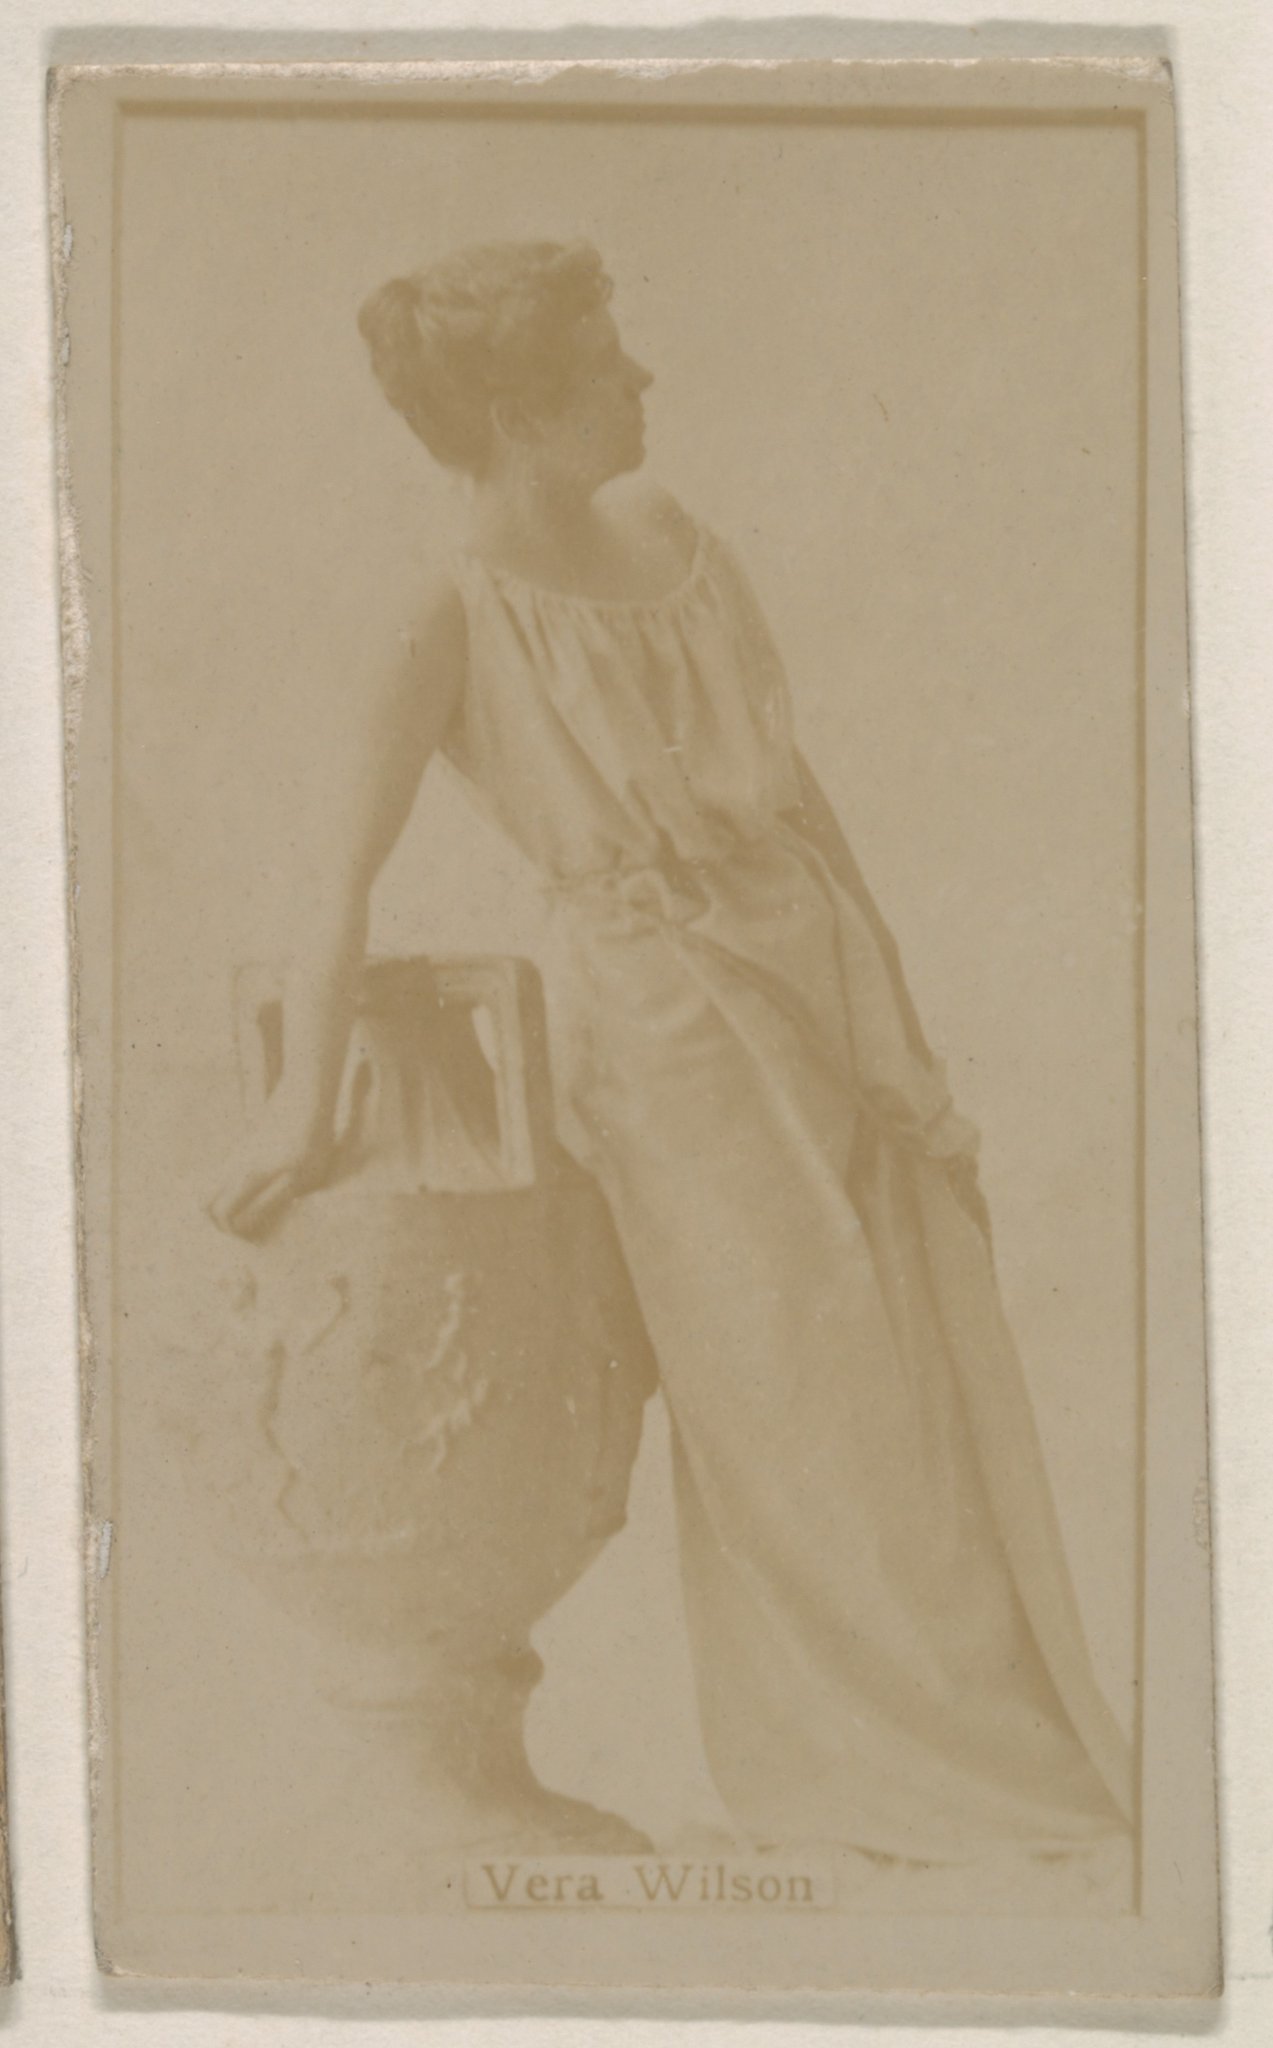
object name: photograph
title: Vera Wilson, from the Actresses series (N245) issued by Kinney Brothers to promote Sweet Caporal Cigarettes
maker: kinney brothers tobacco company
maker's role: publisher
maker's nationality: american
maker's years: 1869-2011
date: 1890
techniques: albumen silver print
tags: women,actresses